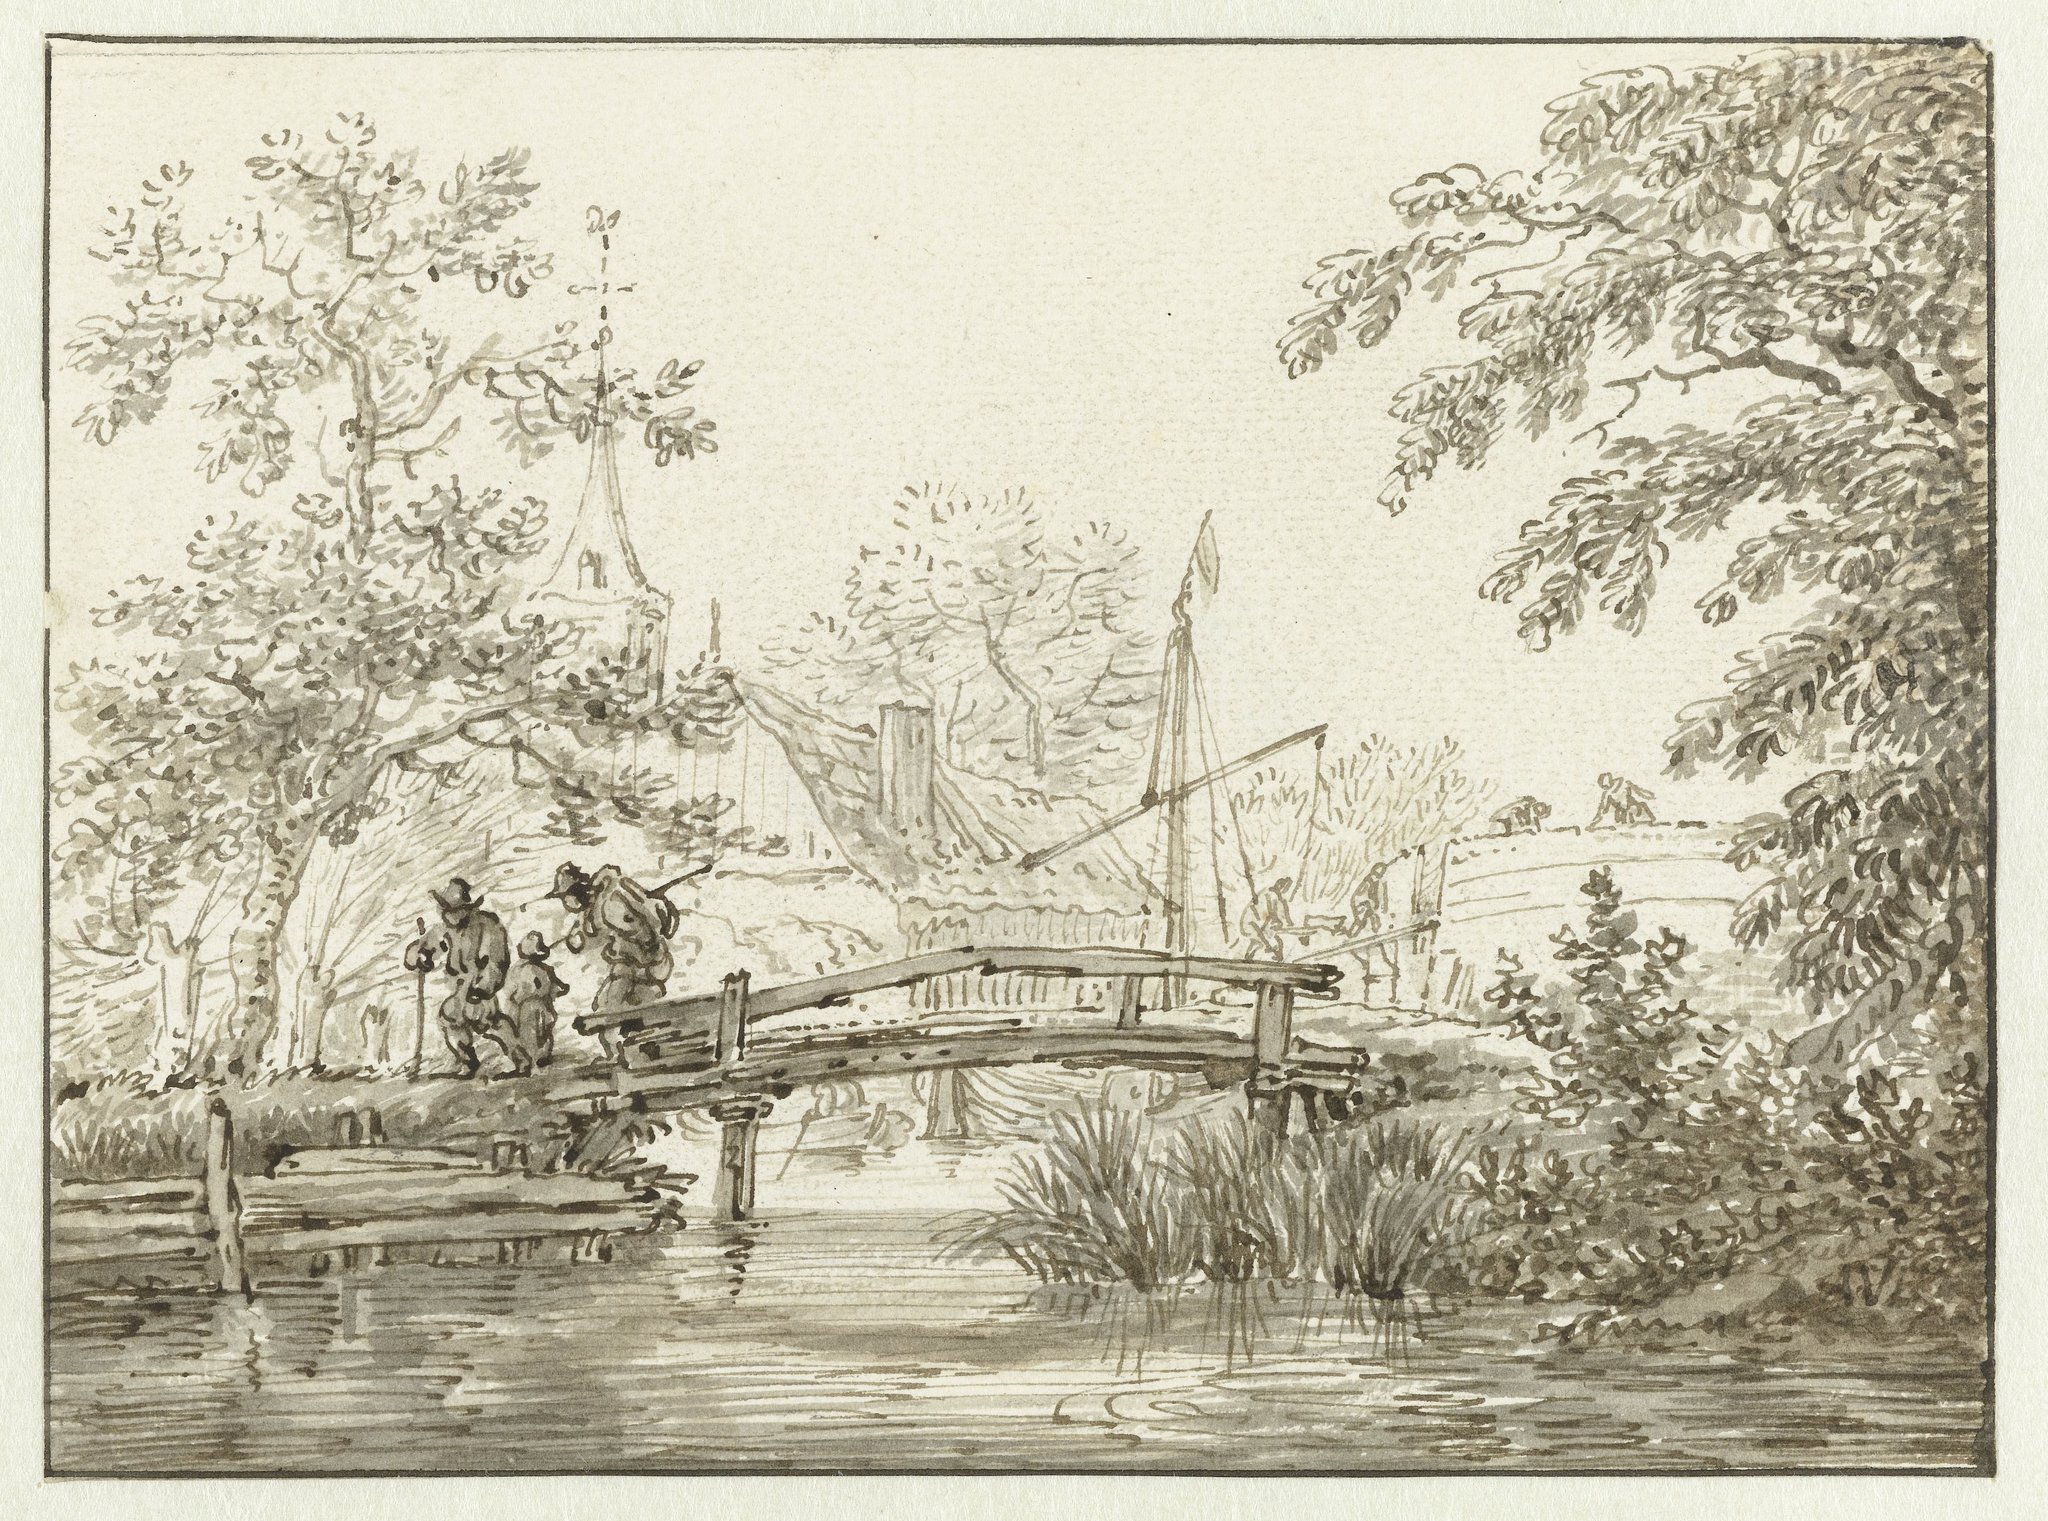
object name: drawing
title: Landschap met een houten bruggetje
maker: allaert van everdingen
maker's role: draughtsman, painter, print maker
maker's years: 1621-1675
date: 1631-1675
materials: ink, paper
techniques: brush, pen